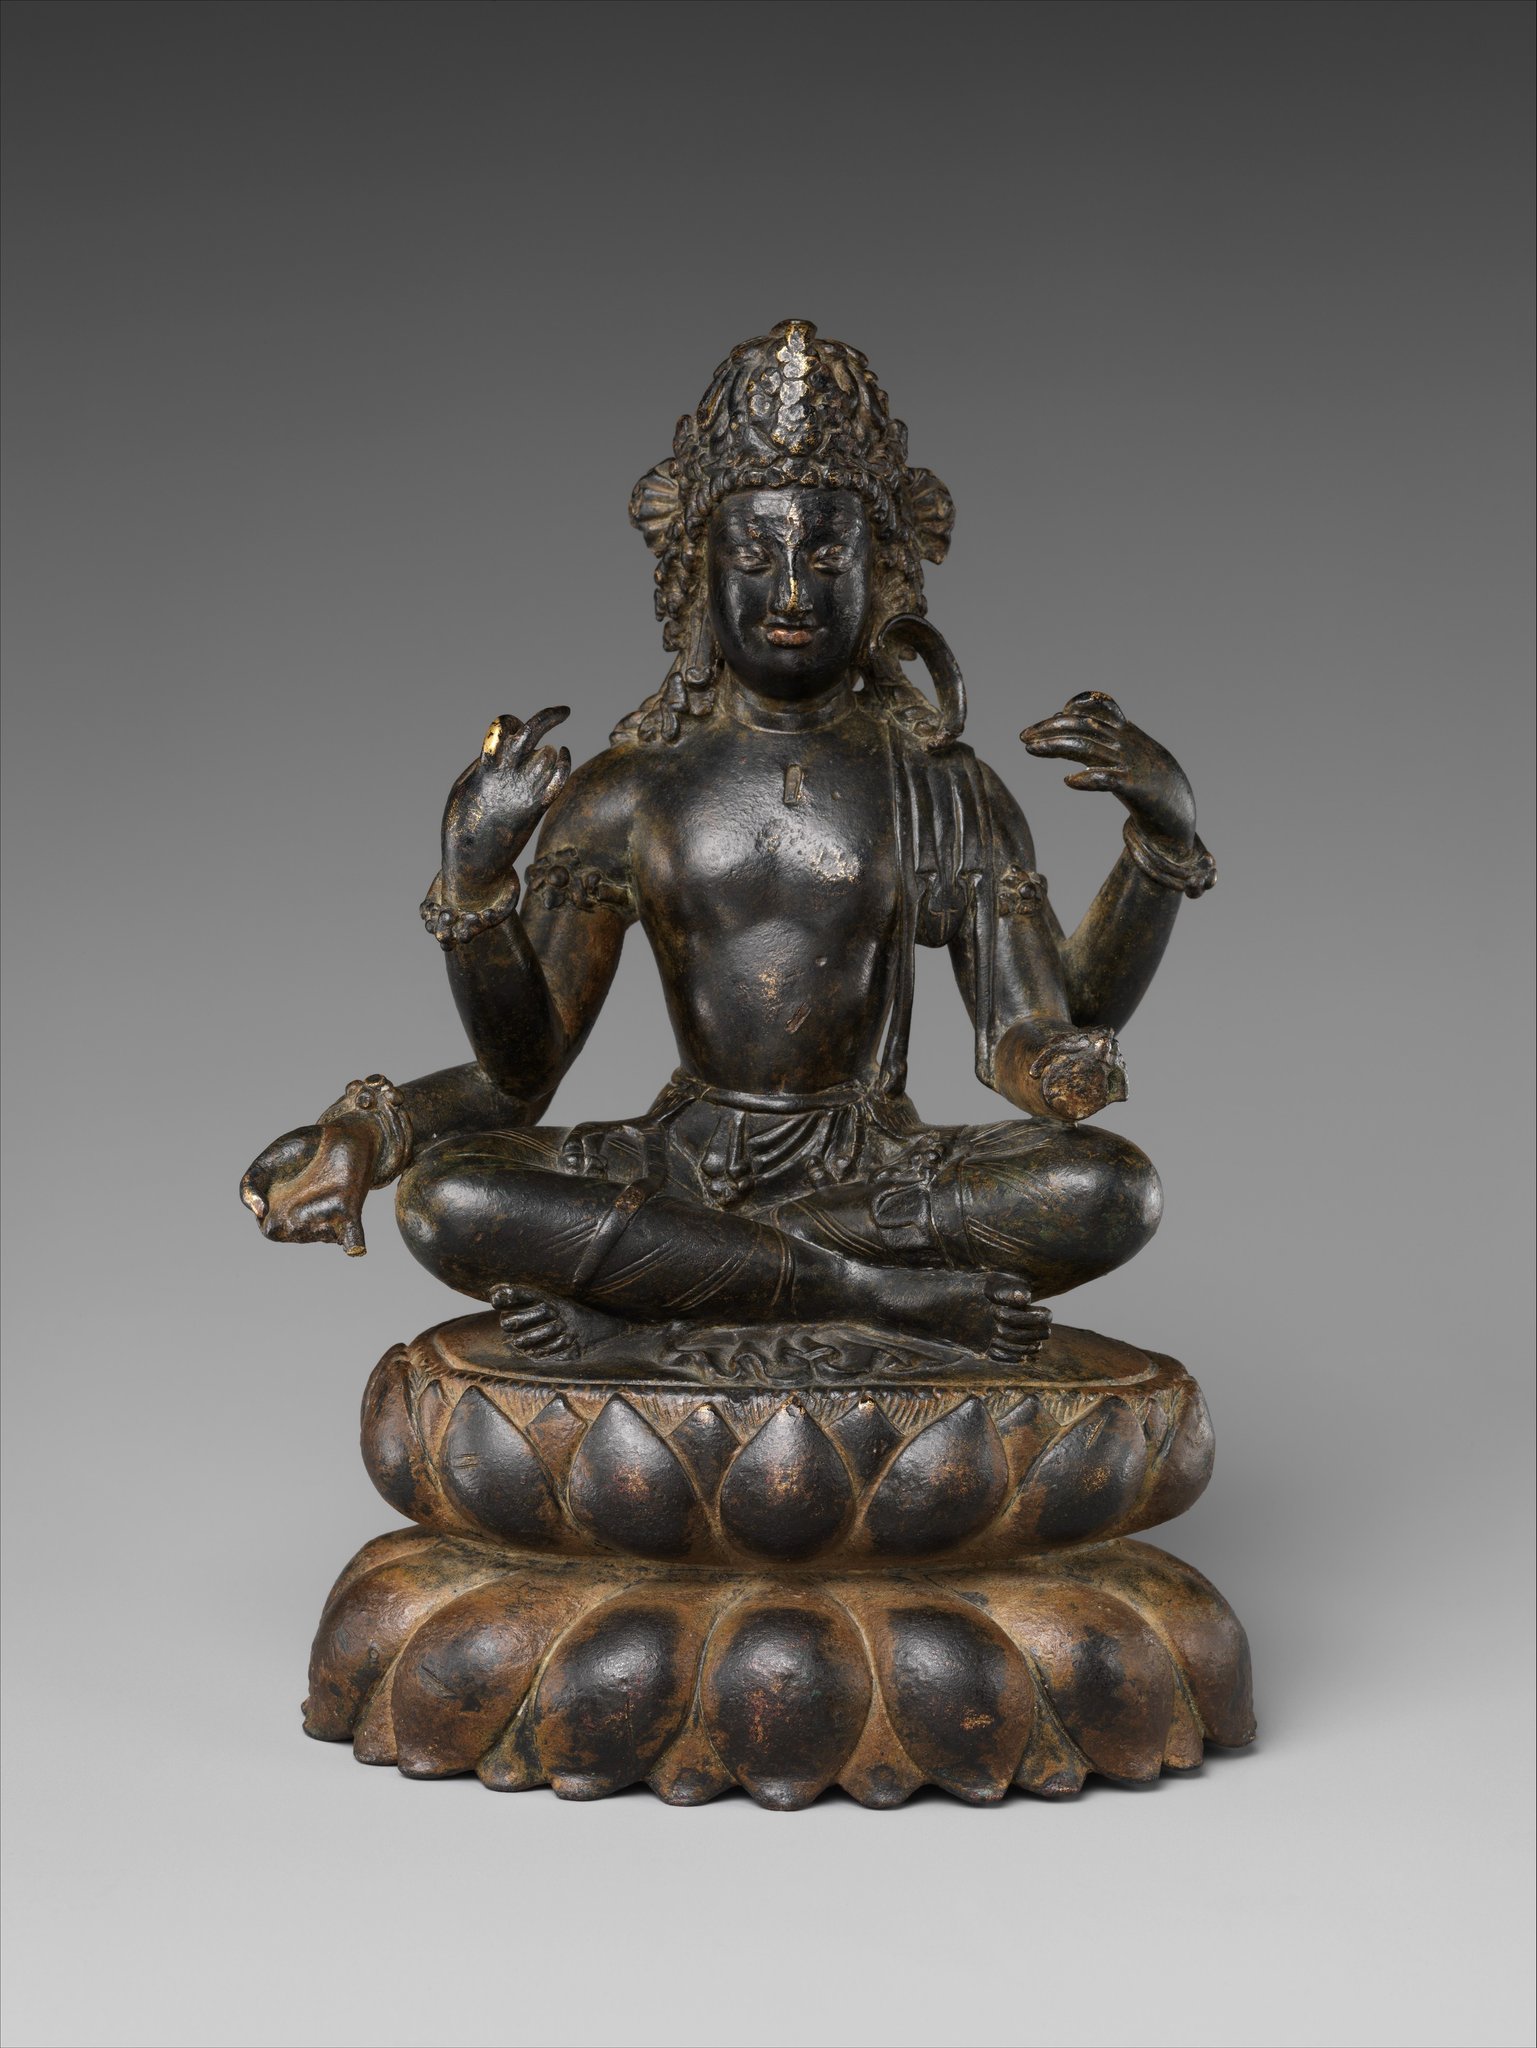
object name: sculpture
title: Bodhisattva Avalokiteshvara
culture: pakistani, swat valley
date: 601-700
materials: brass, copper, silver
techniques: inlay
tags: swat valley,buddhism,avalokiteshvara,bodhisattvas